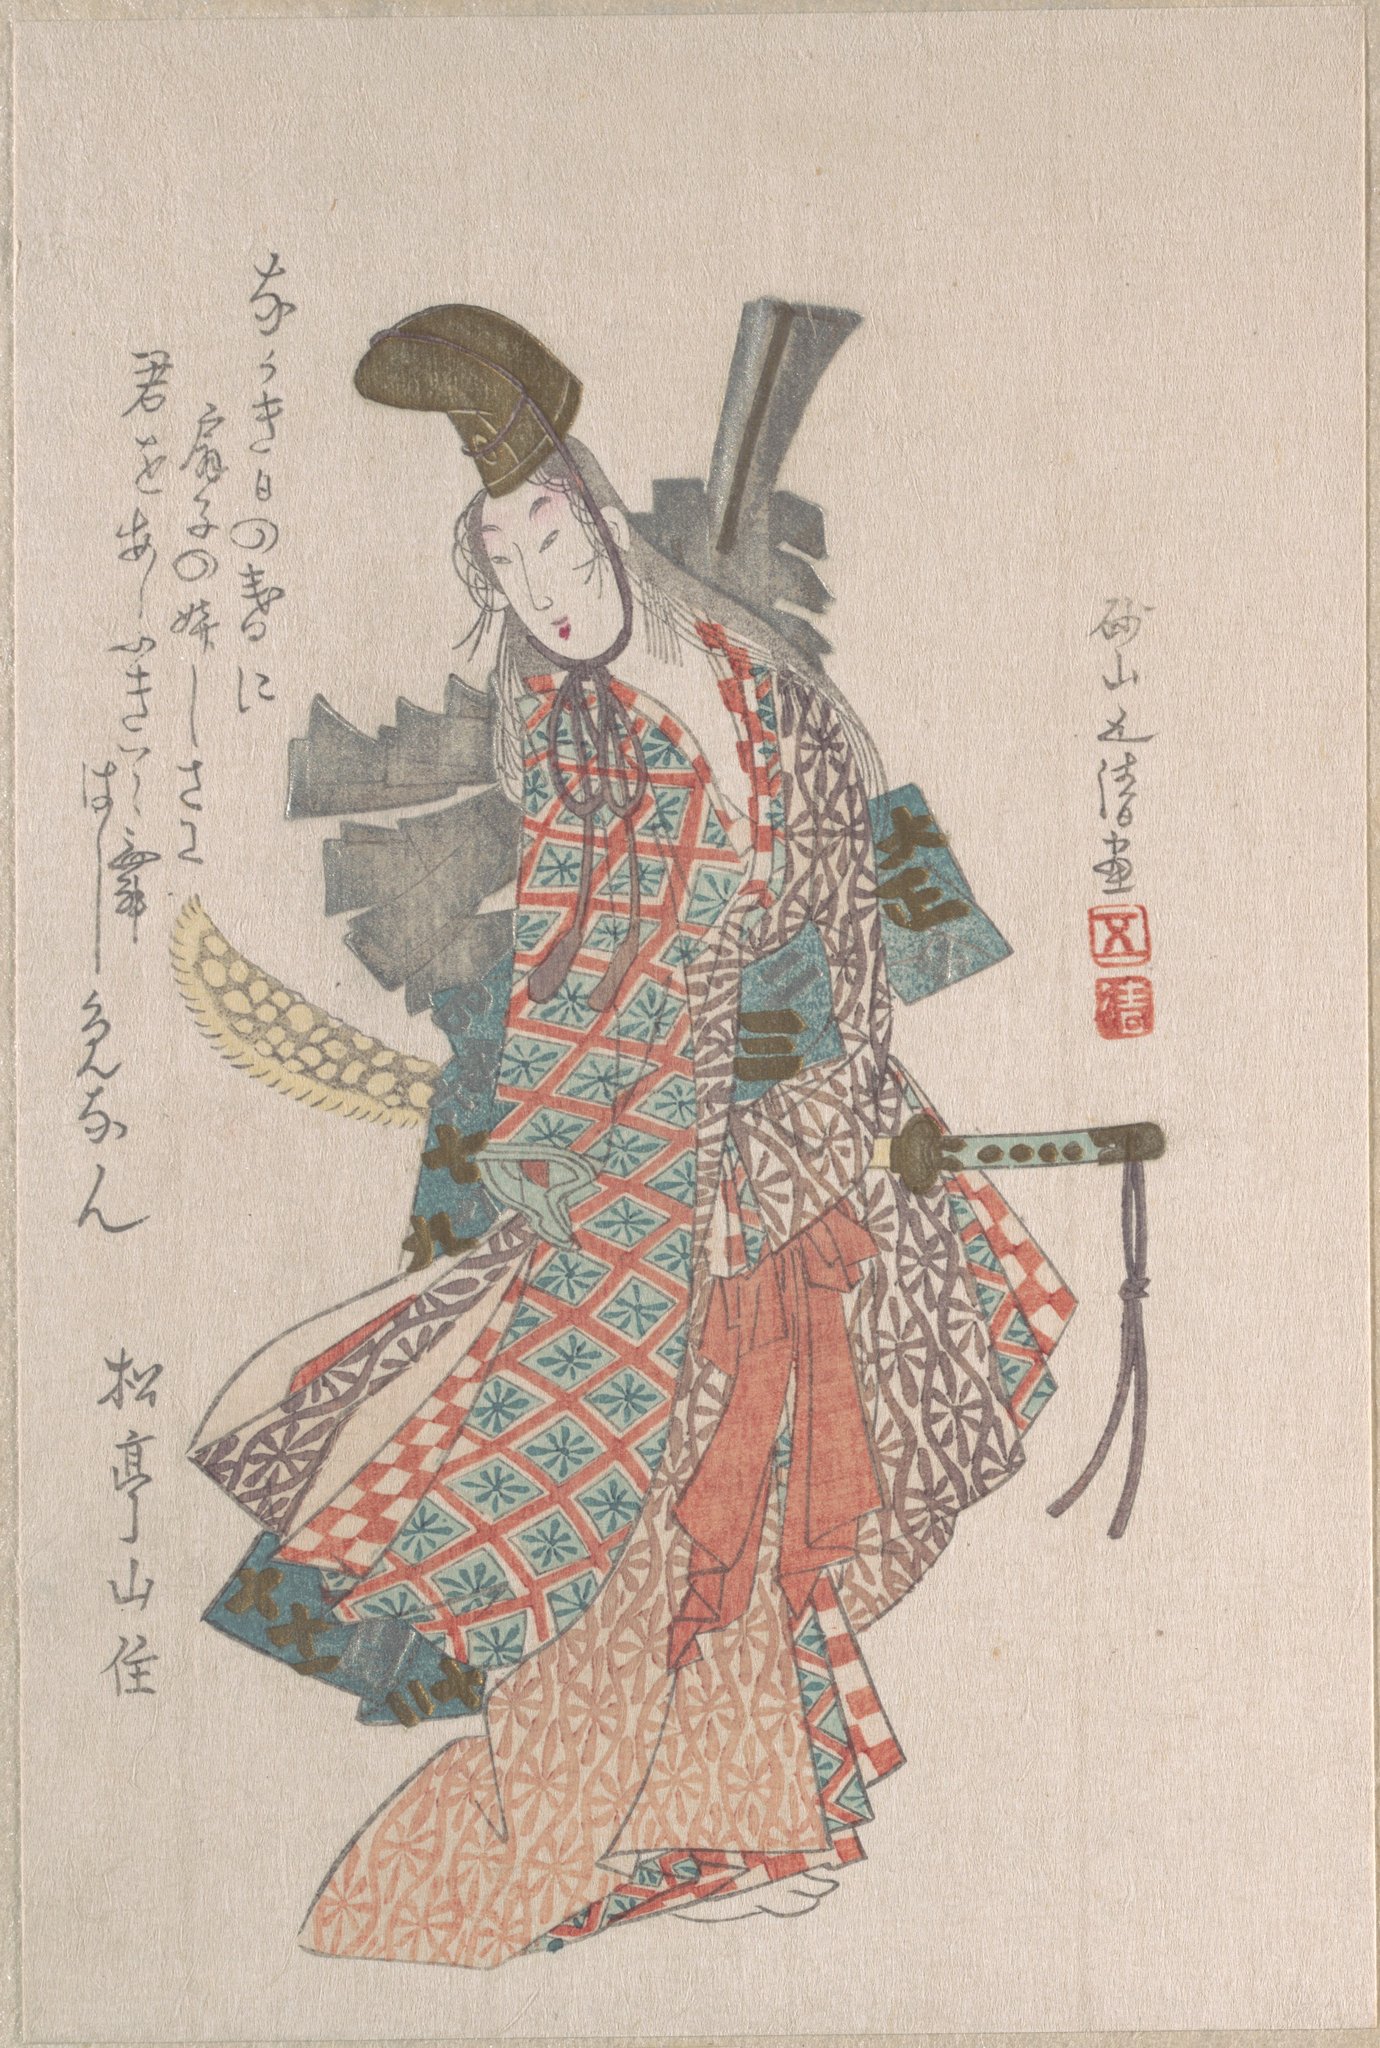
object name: print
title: Dancing Girl Wearing a Sword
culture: japanese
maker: sunayama gosei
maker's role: artist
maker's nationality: japanese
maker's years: 1700-1900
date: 1700-1899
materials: ink, paper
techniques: surimono, woodblock print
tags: swords,women,dancing